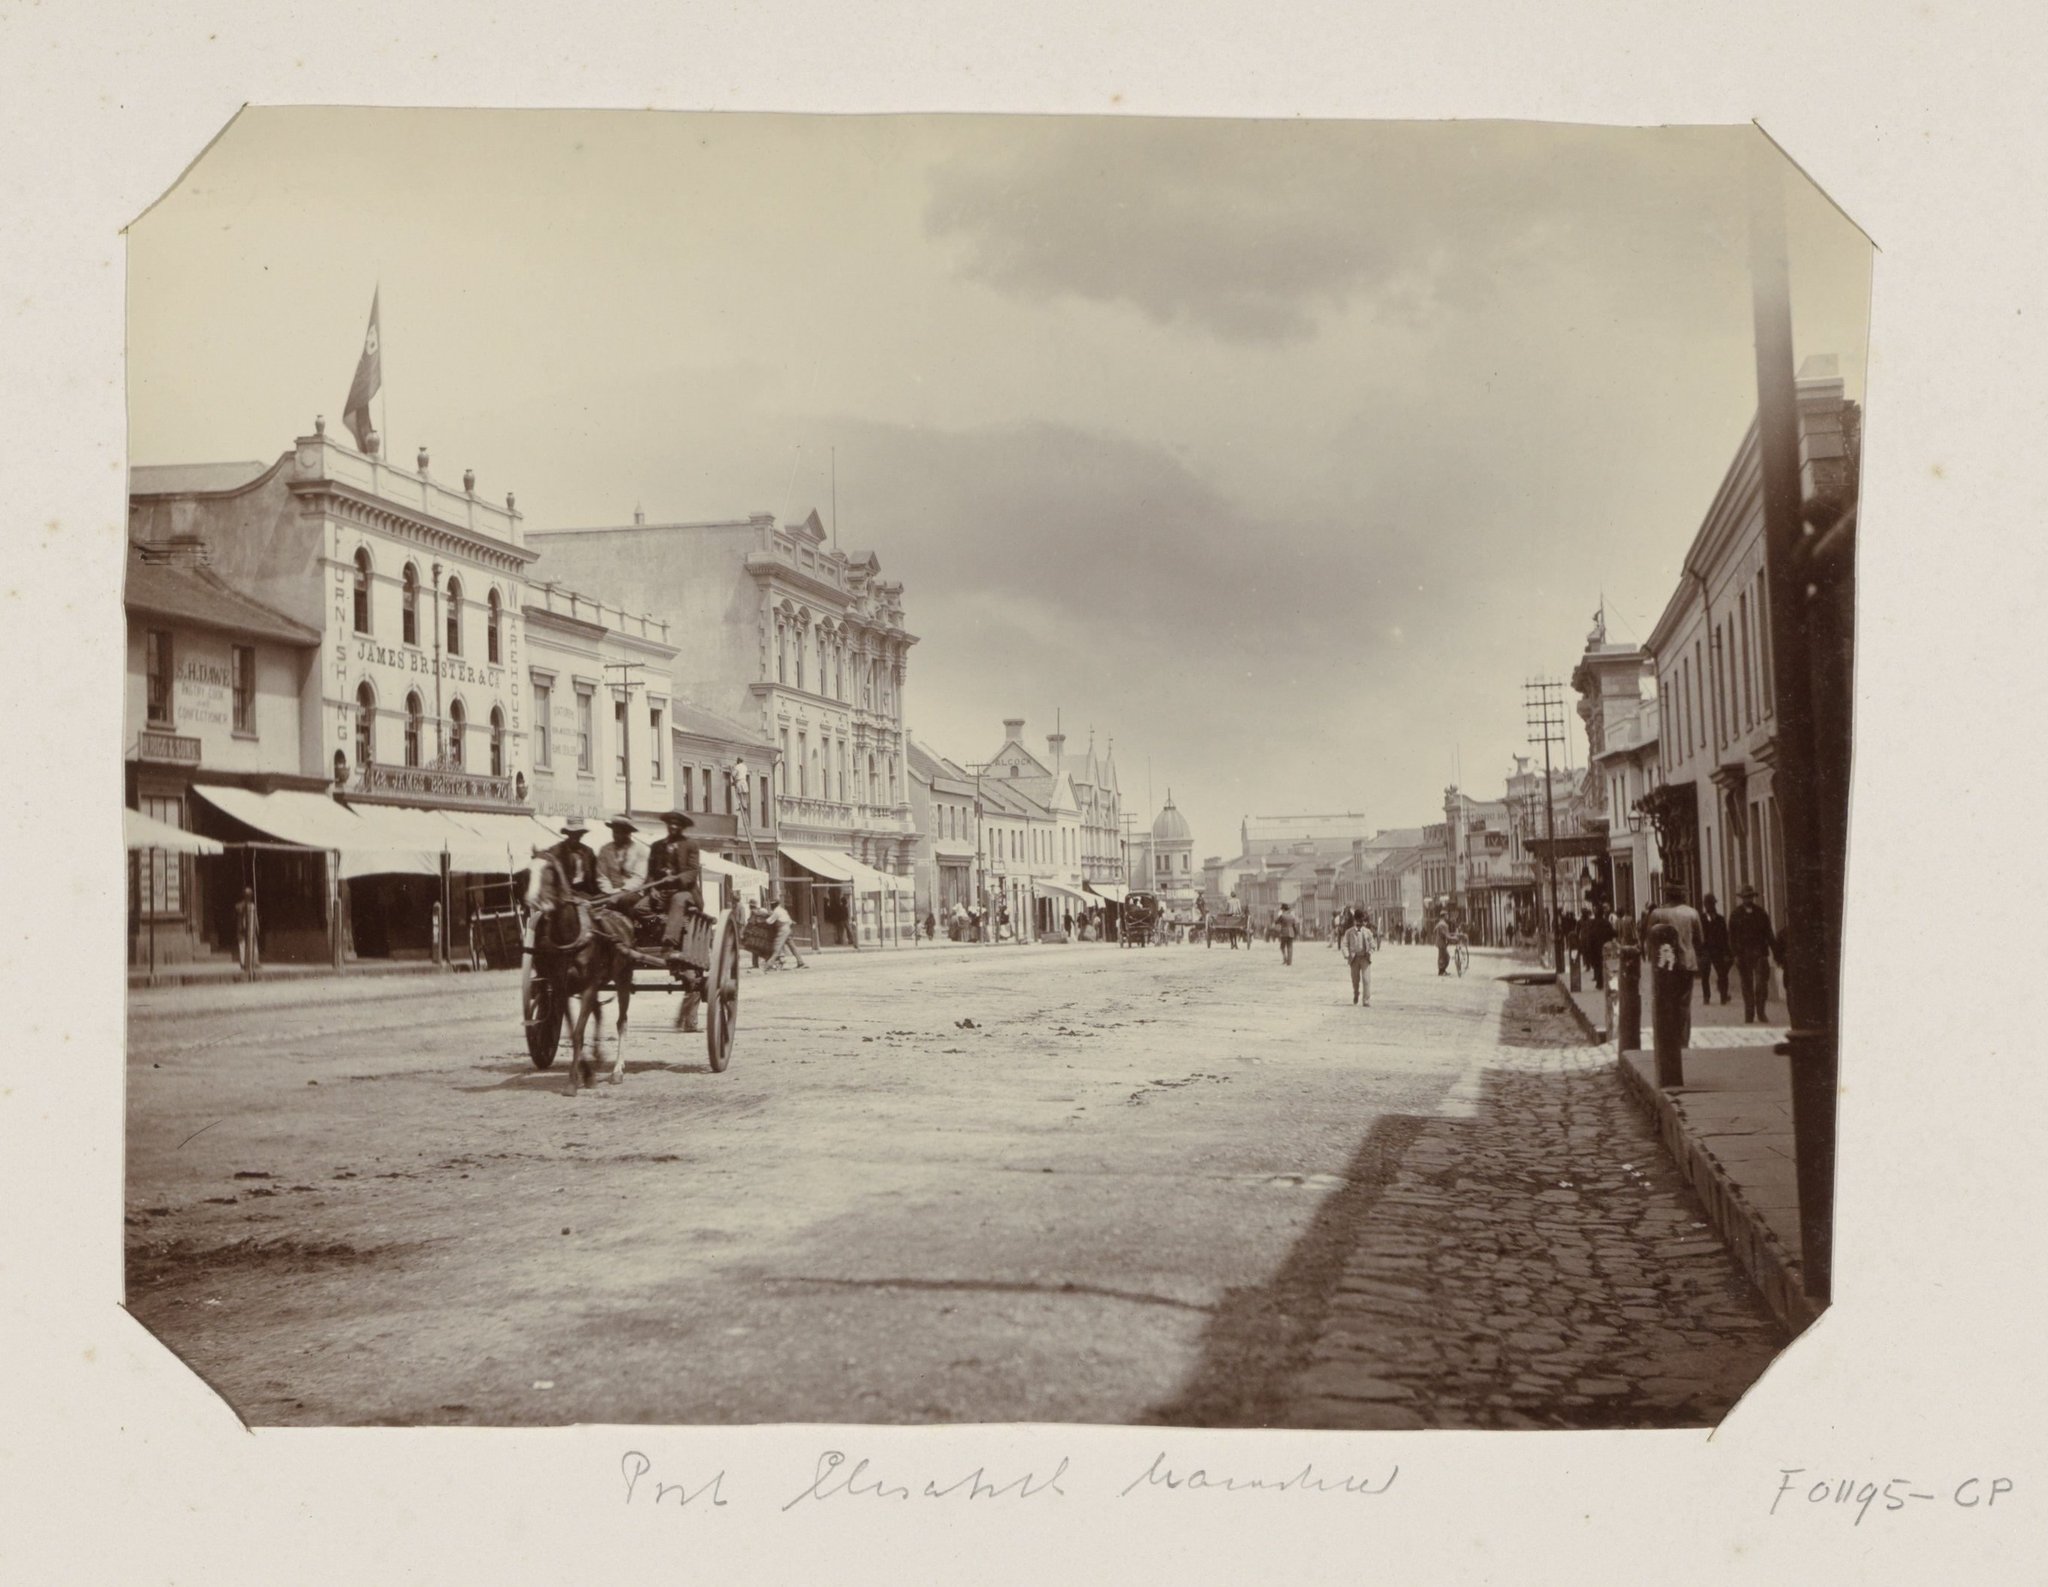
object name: photograph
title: Mainstreet in Port Elizabeth met voorbijgangers en paardenkoetsen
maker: Anonymous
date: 1880-1910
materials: cardboard, paper, photographic support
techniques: gelatin silver print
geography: port elizabeth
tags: street (+ city(-scape) with figures, staffage)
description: Onderdeel van Fotoalbum van een reis door de Verenigde Staten, Honolulu, Nederlands-Indië, Aden, Zanzibar en Zuidelijk Afrika.